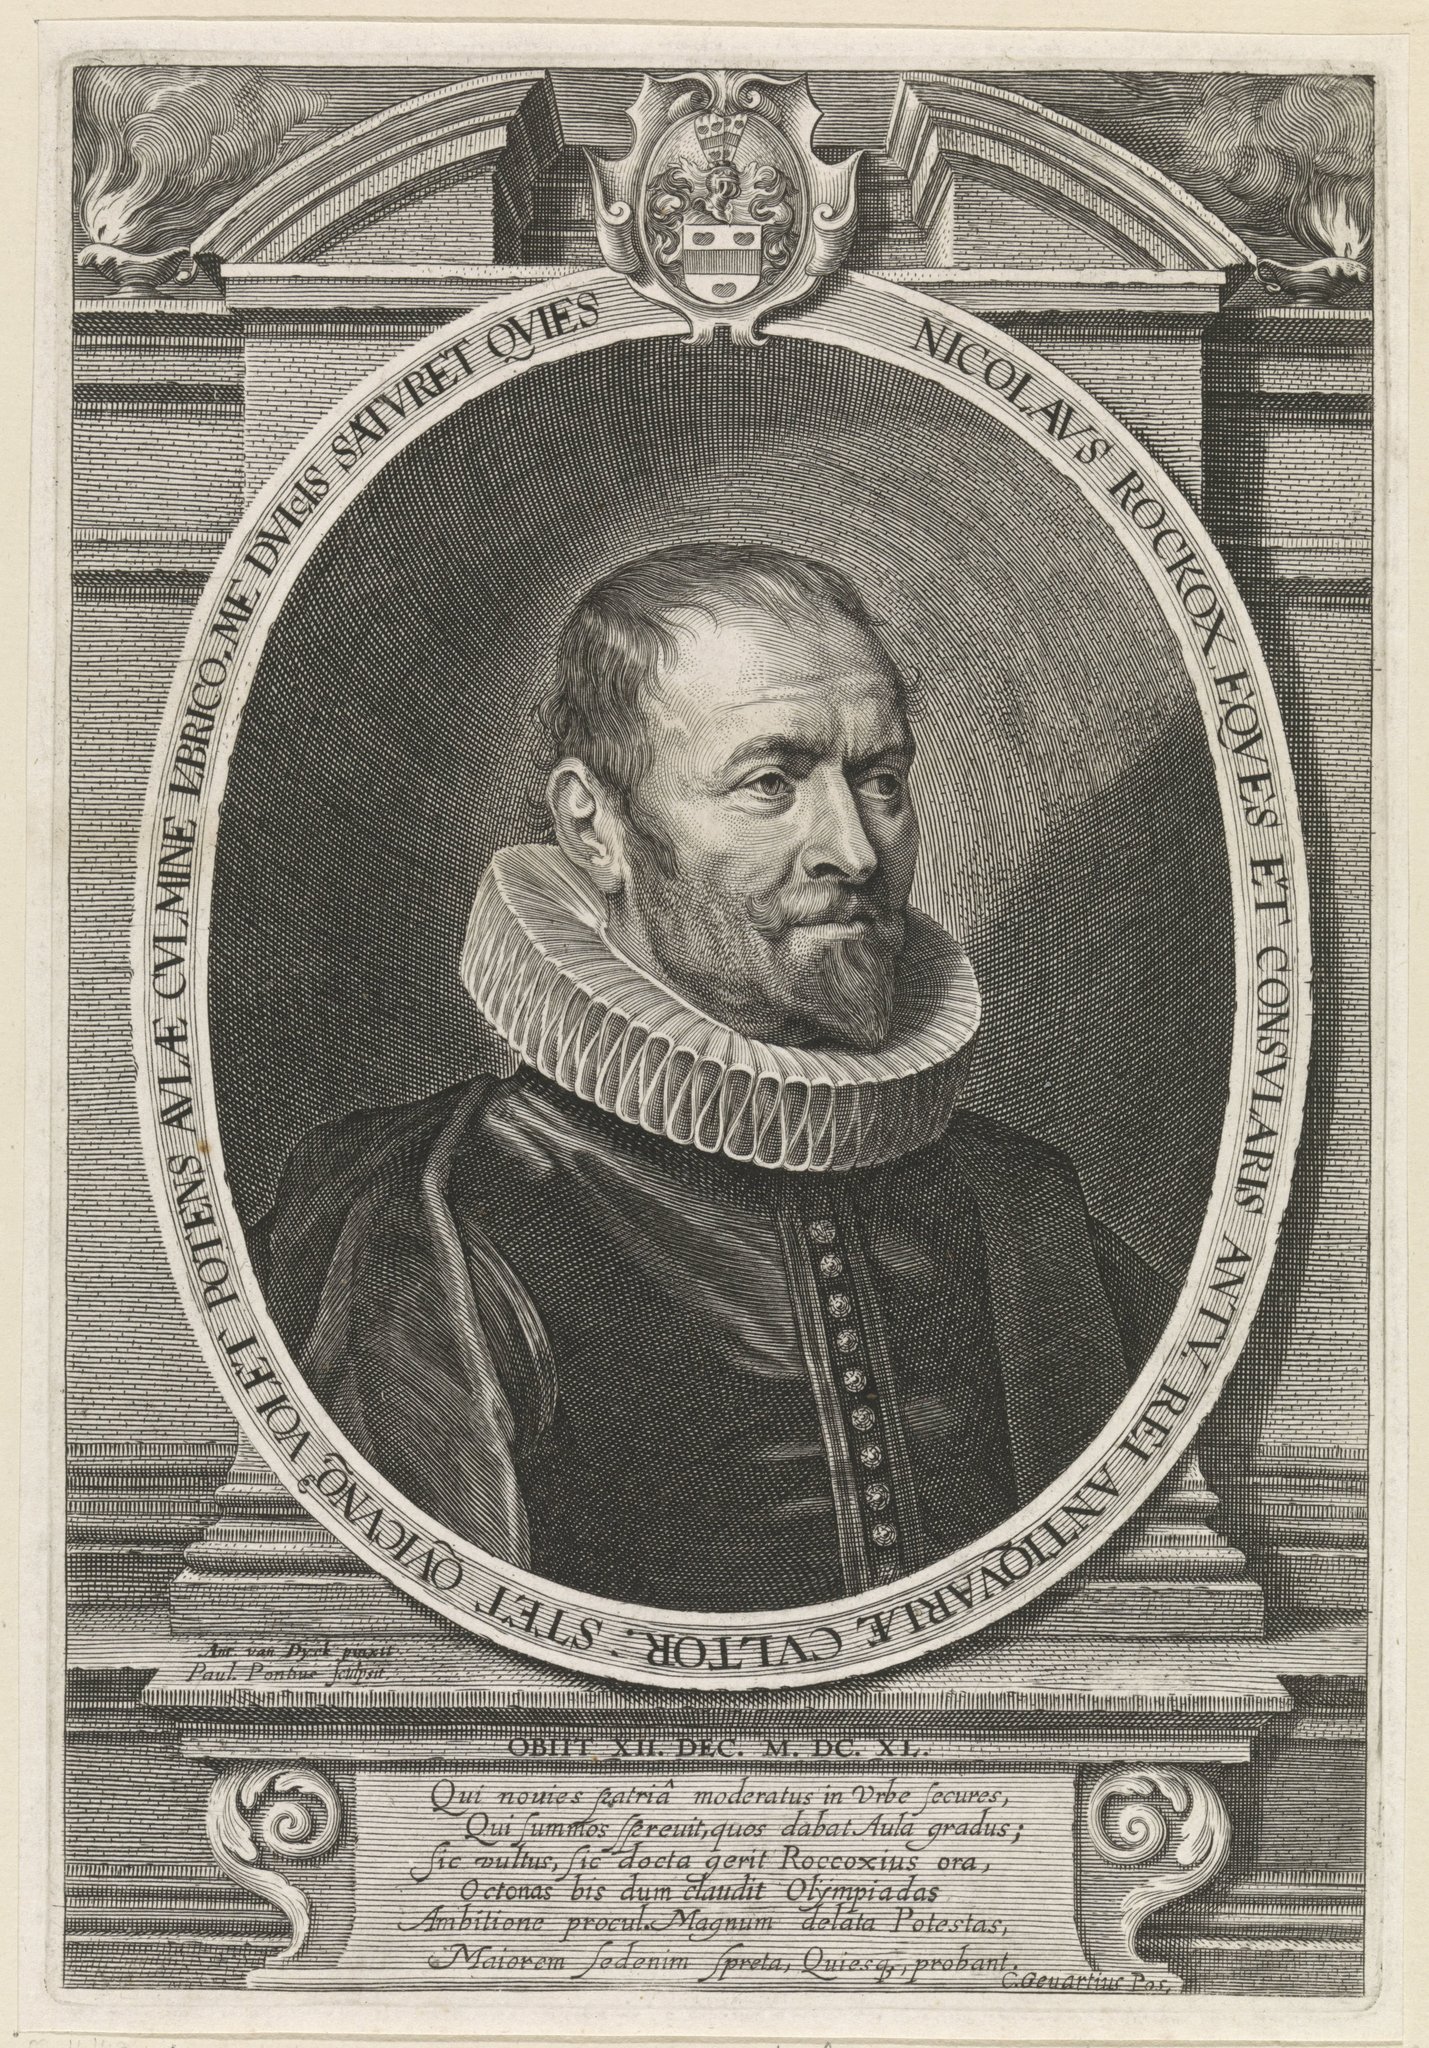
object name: print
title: Portret van Nicolaas Rockox jr., op 79-jarige leeftijd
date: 1639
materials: paper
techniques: engraving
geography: antwerp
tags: antwerp, mayor, nikolaas rockox, armorial bearing, heraldry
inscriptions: collector's mark: Lugt 240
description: Portret van Nicolaas Rockox jr., burgemeester van Antwerpen, bekroond met zijn wapenschild. In het kader op de piëdestal een zesregelig lofdicht in het Latijn.